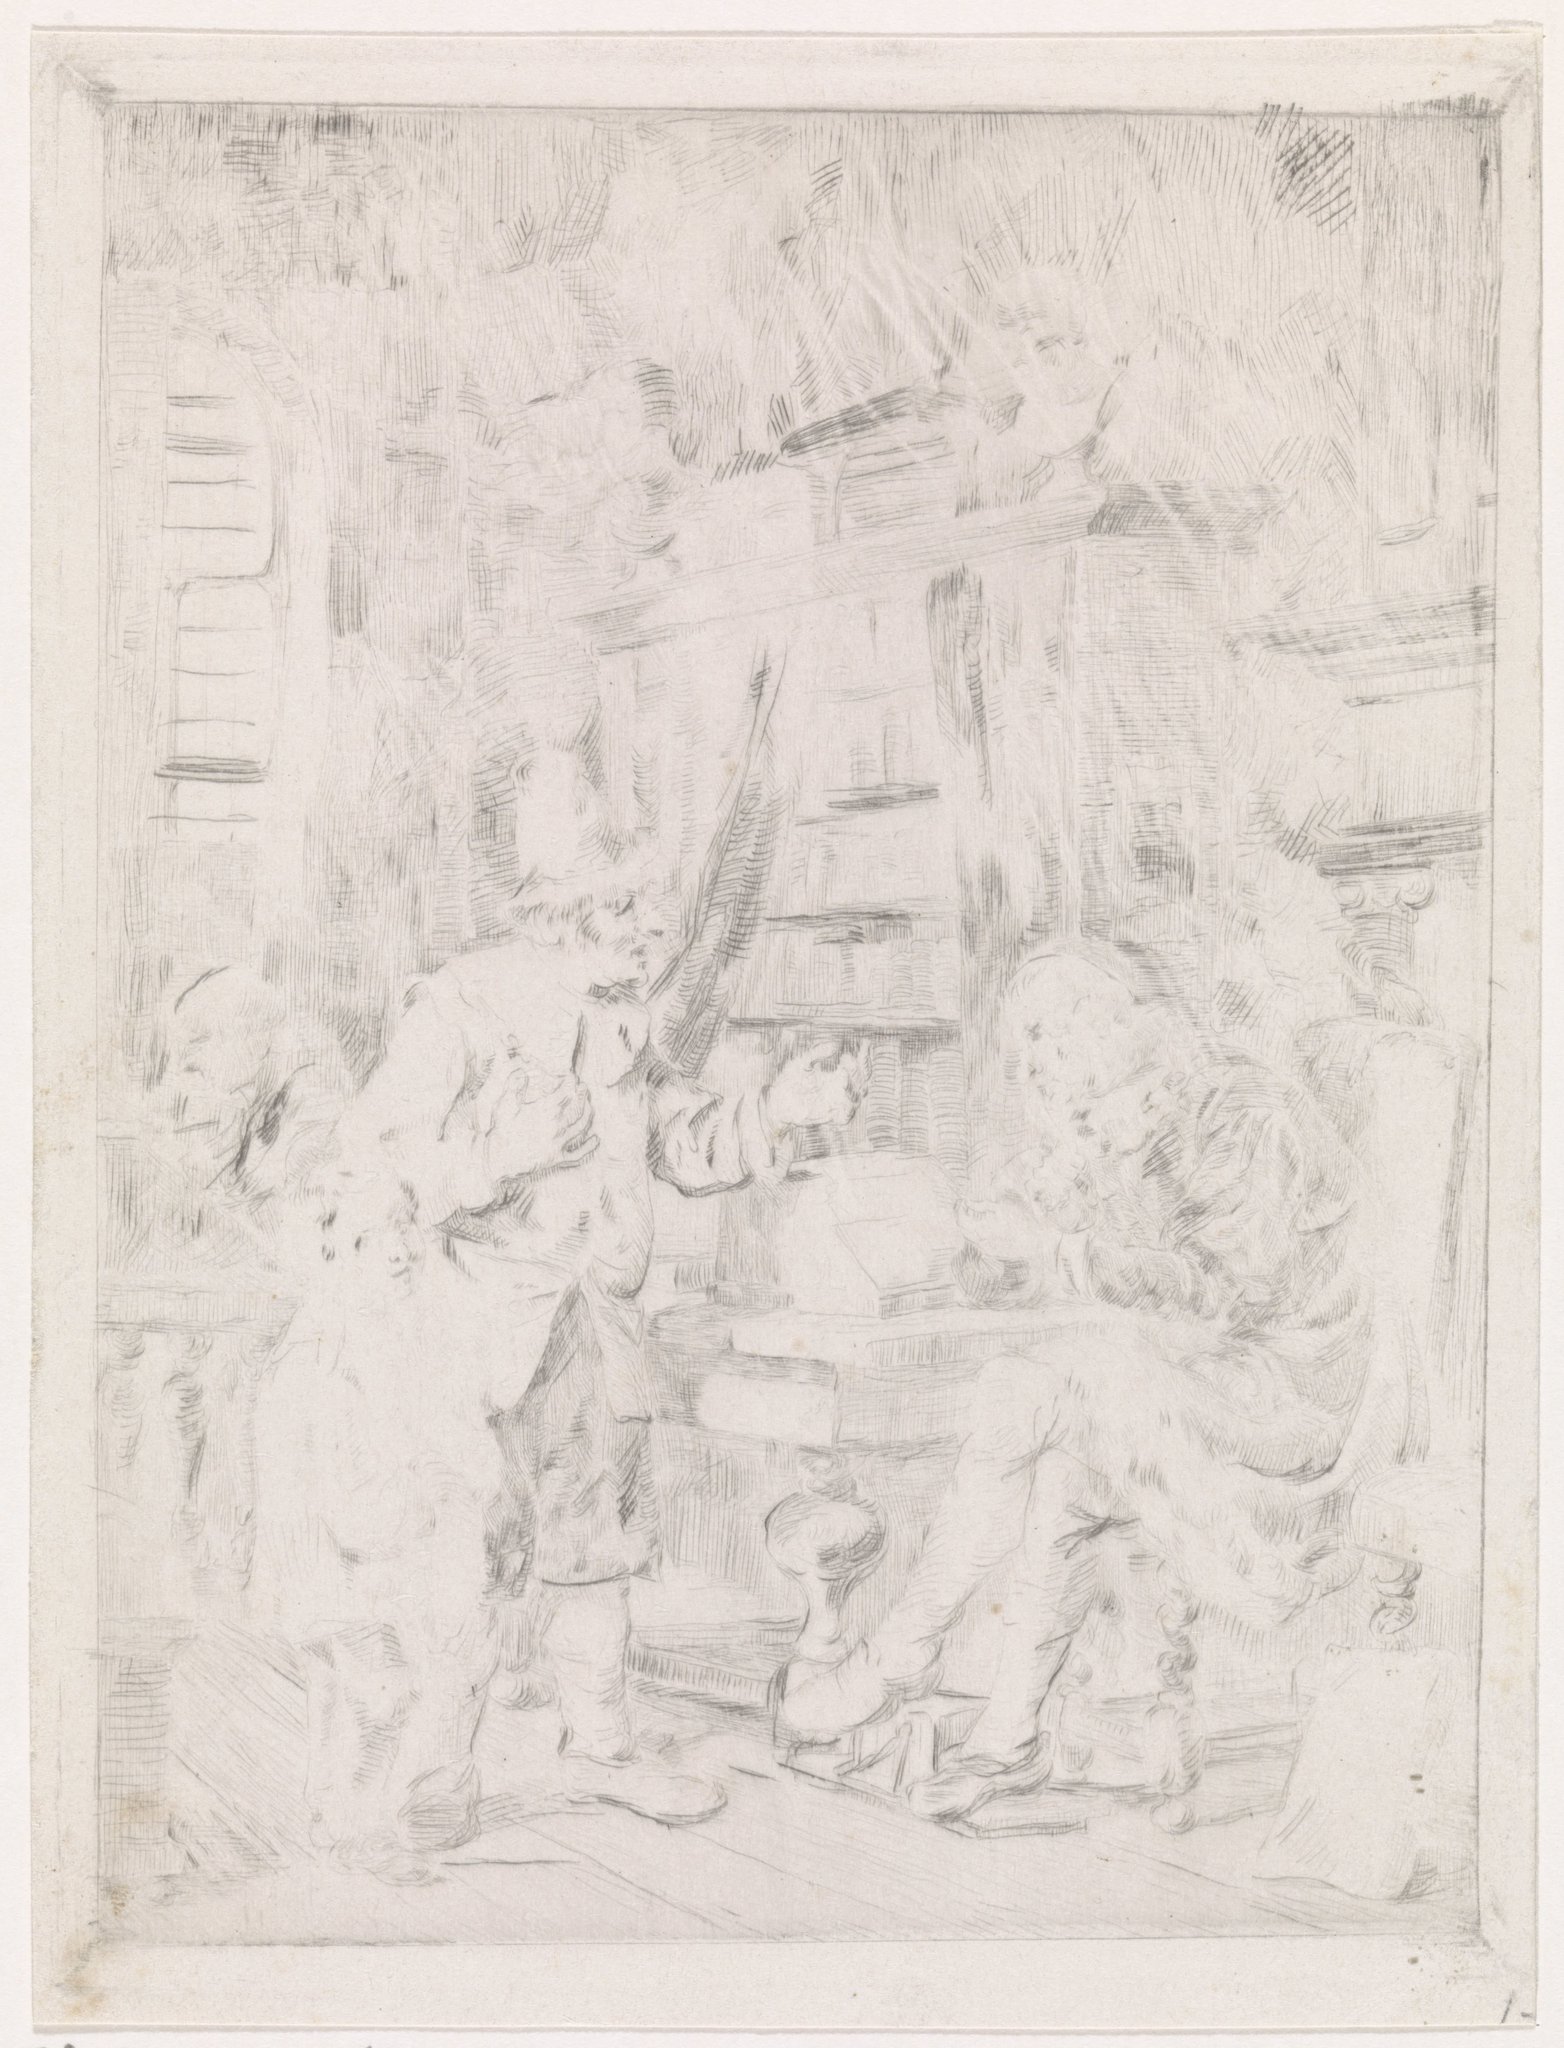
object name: print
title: Bij de advocaat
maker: david van der kellen (1827-1895)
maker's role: draughtsman, print maker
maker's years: 1827-1895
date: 1837-1882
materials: paper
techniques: etching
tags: lawyer, attorney at law, sausage, ham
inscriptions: collector's mark: Lugt 2228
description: In een vertrek zit een rijkelijk geklede advocaat voor de schouw bij een lessenaar, waarvoor een gebarende man met hoed staat. Bij de man staat een jongetje dat in de richting van de toeschouwer kijkt en een ham en worst bij zich heeft. De man vraagt mogelijk raad aan de advocaat, die de man met een handgebaar duidelijk maakt dat raad geld kost. Op de achtergrond staat een boekenkast met daarop twee bustes en achter een hekje is het silhouet van een figuur bij een lessenaar zichtbaar.